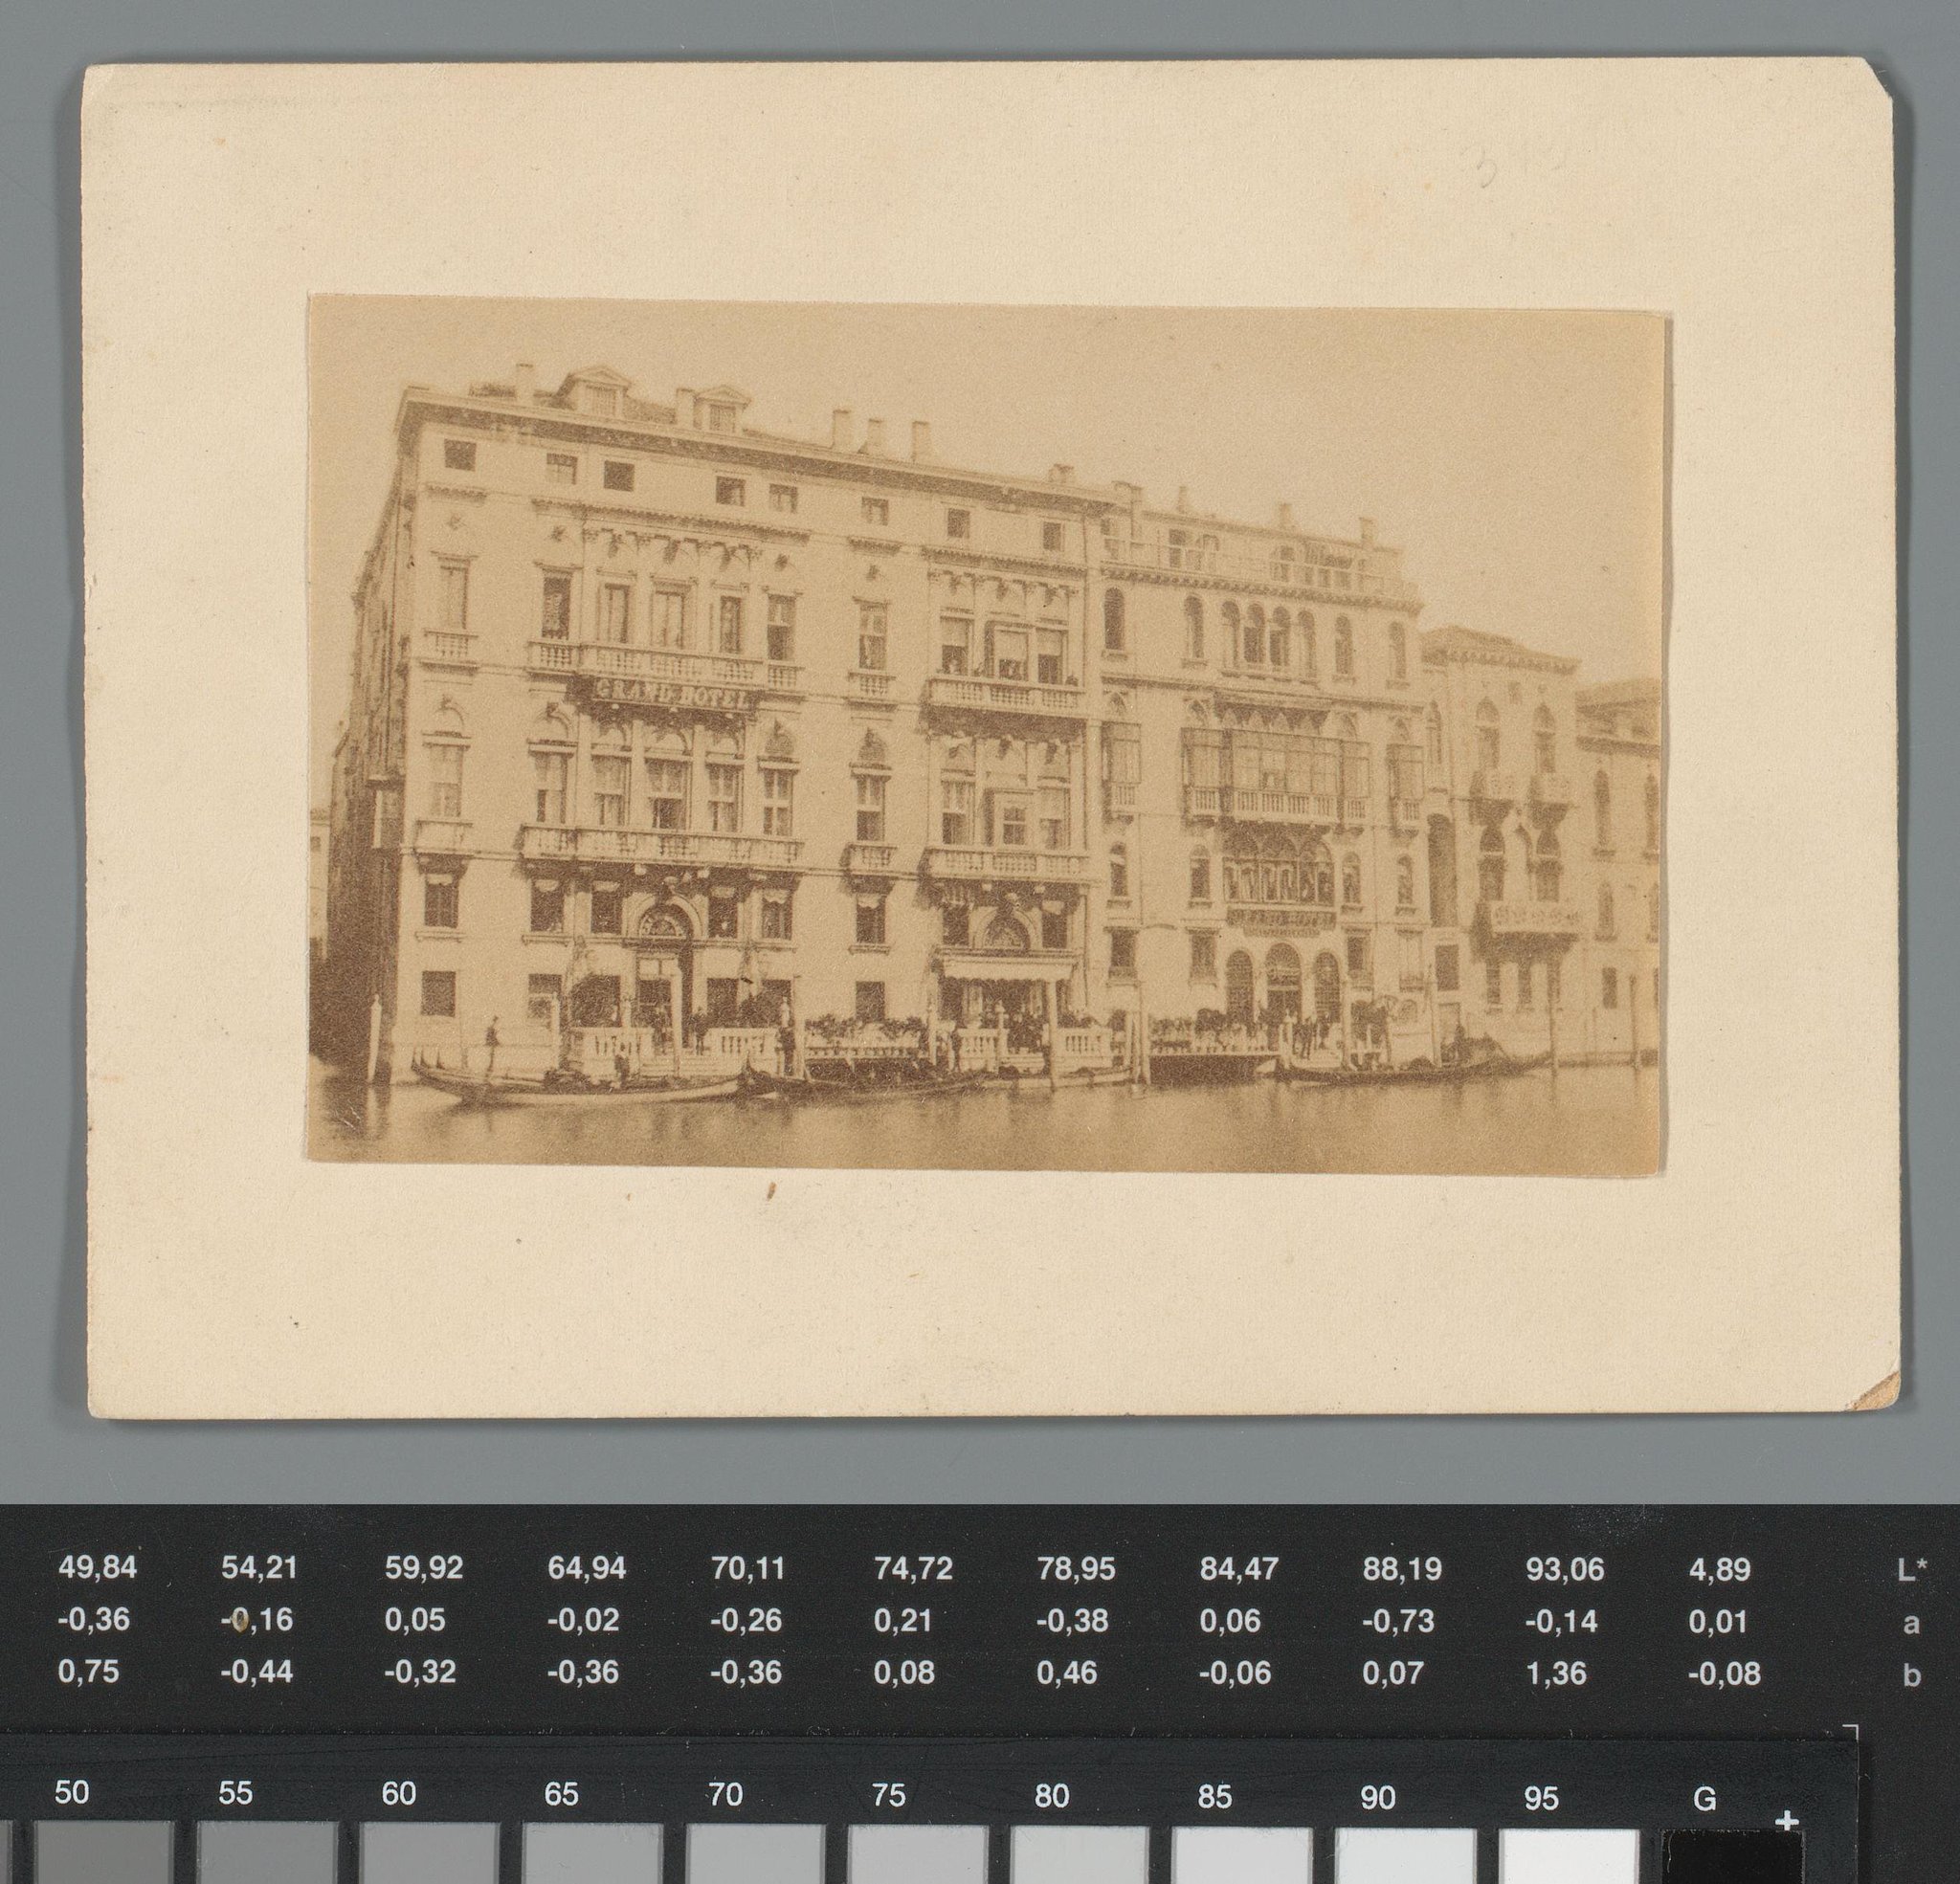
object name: photograph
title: Reclame voor het Grand Hotel New York in Venetië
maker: Anonymous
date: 1850-1915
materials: cardboard, photographic support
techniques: albumen print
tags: advertising, hotel, hostelry, inn, venice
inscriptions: inscription: ‘(...)/ Venise Etab. Kirchmayer & Scozzi’